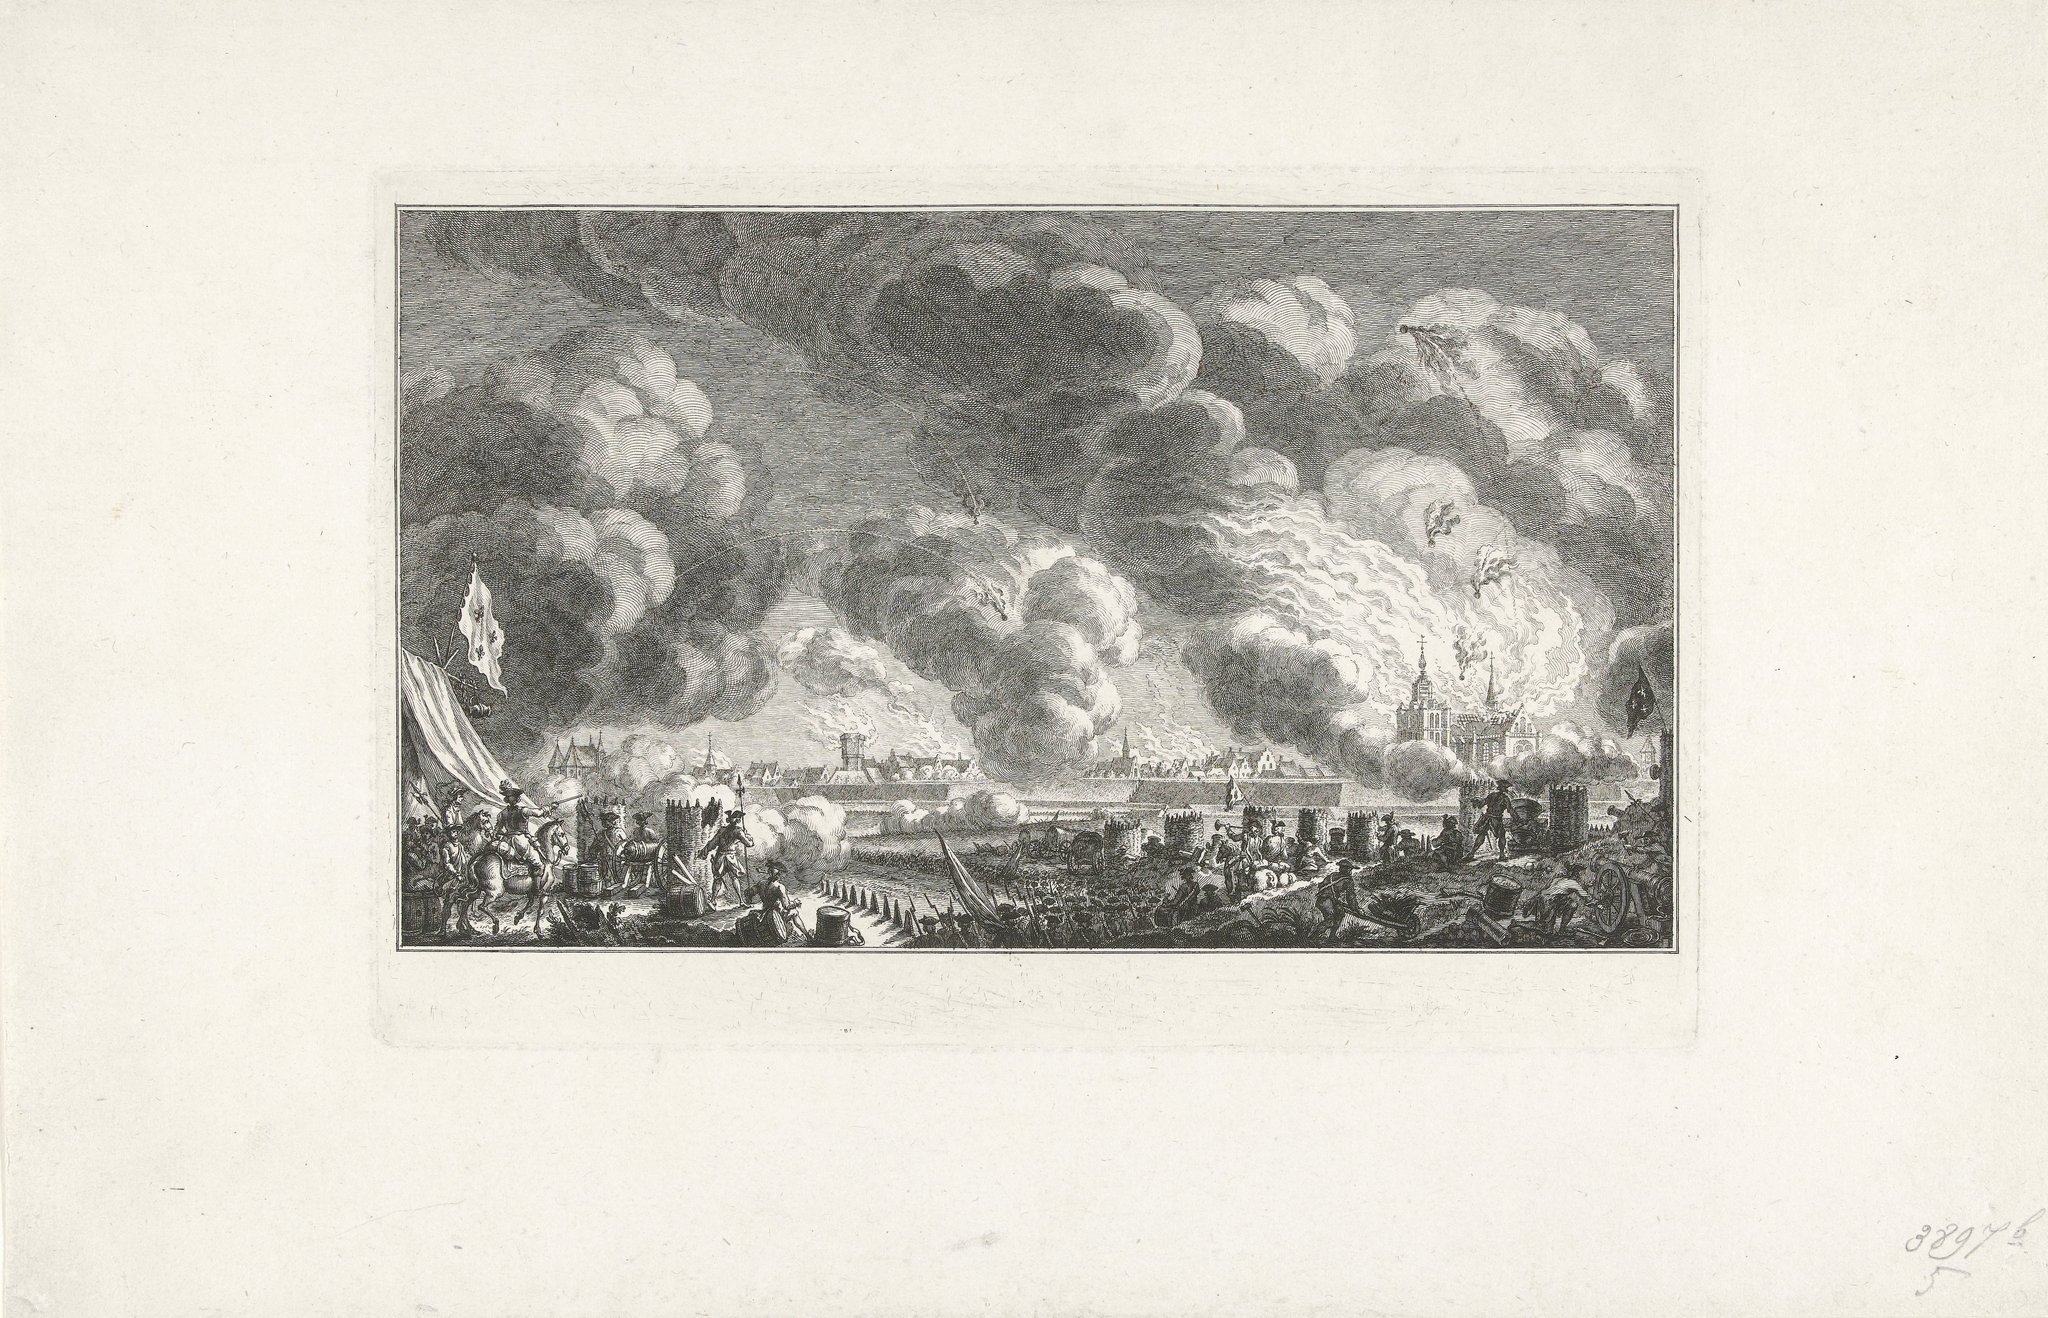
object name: book illustration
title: Bombardement van Bergen op Zoom, 1747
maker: simon fokke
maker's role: draughtsman, print maker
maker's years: 1712-1784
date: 1772-1780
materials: paper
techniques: etching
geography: northern netherlands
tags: bombardment ~ siege, bergen op zoom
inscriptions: collector's mark: Lugt 2228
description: Prent ook gebruikt in: Beschryving der stad Bergen op den Zoom (…). 1e druk. Amsterdam: Arend Fokke Simonsz., 1780. Muller geeft aan dat de prenten door Simon Fokke in 1772 naar de tekeningen van Pronk uit 1748 zijn vervaardigd. In de Collecties Thuis in Brabant (collecties in Brabantse musea en archieven) is een ontwerptekening (met inv.nr.: BC-Tha oai:tha.uvt.nl:709121) voor deze prent in de serie bewaard met de annotatie: Hoogstraat. na t Leven geschest (sic) door C.Pronk 1748. opgetekent door S. Fokke 1772.